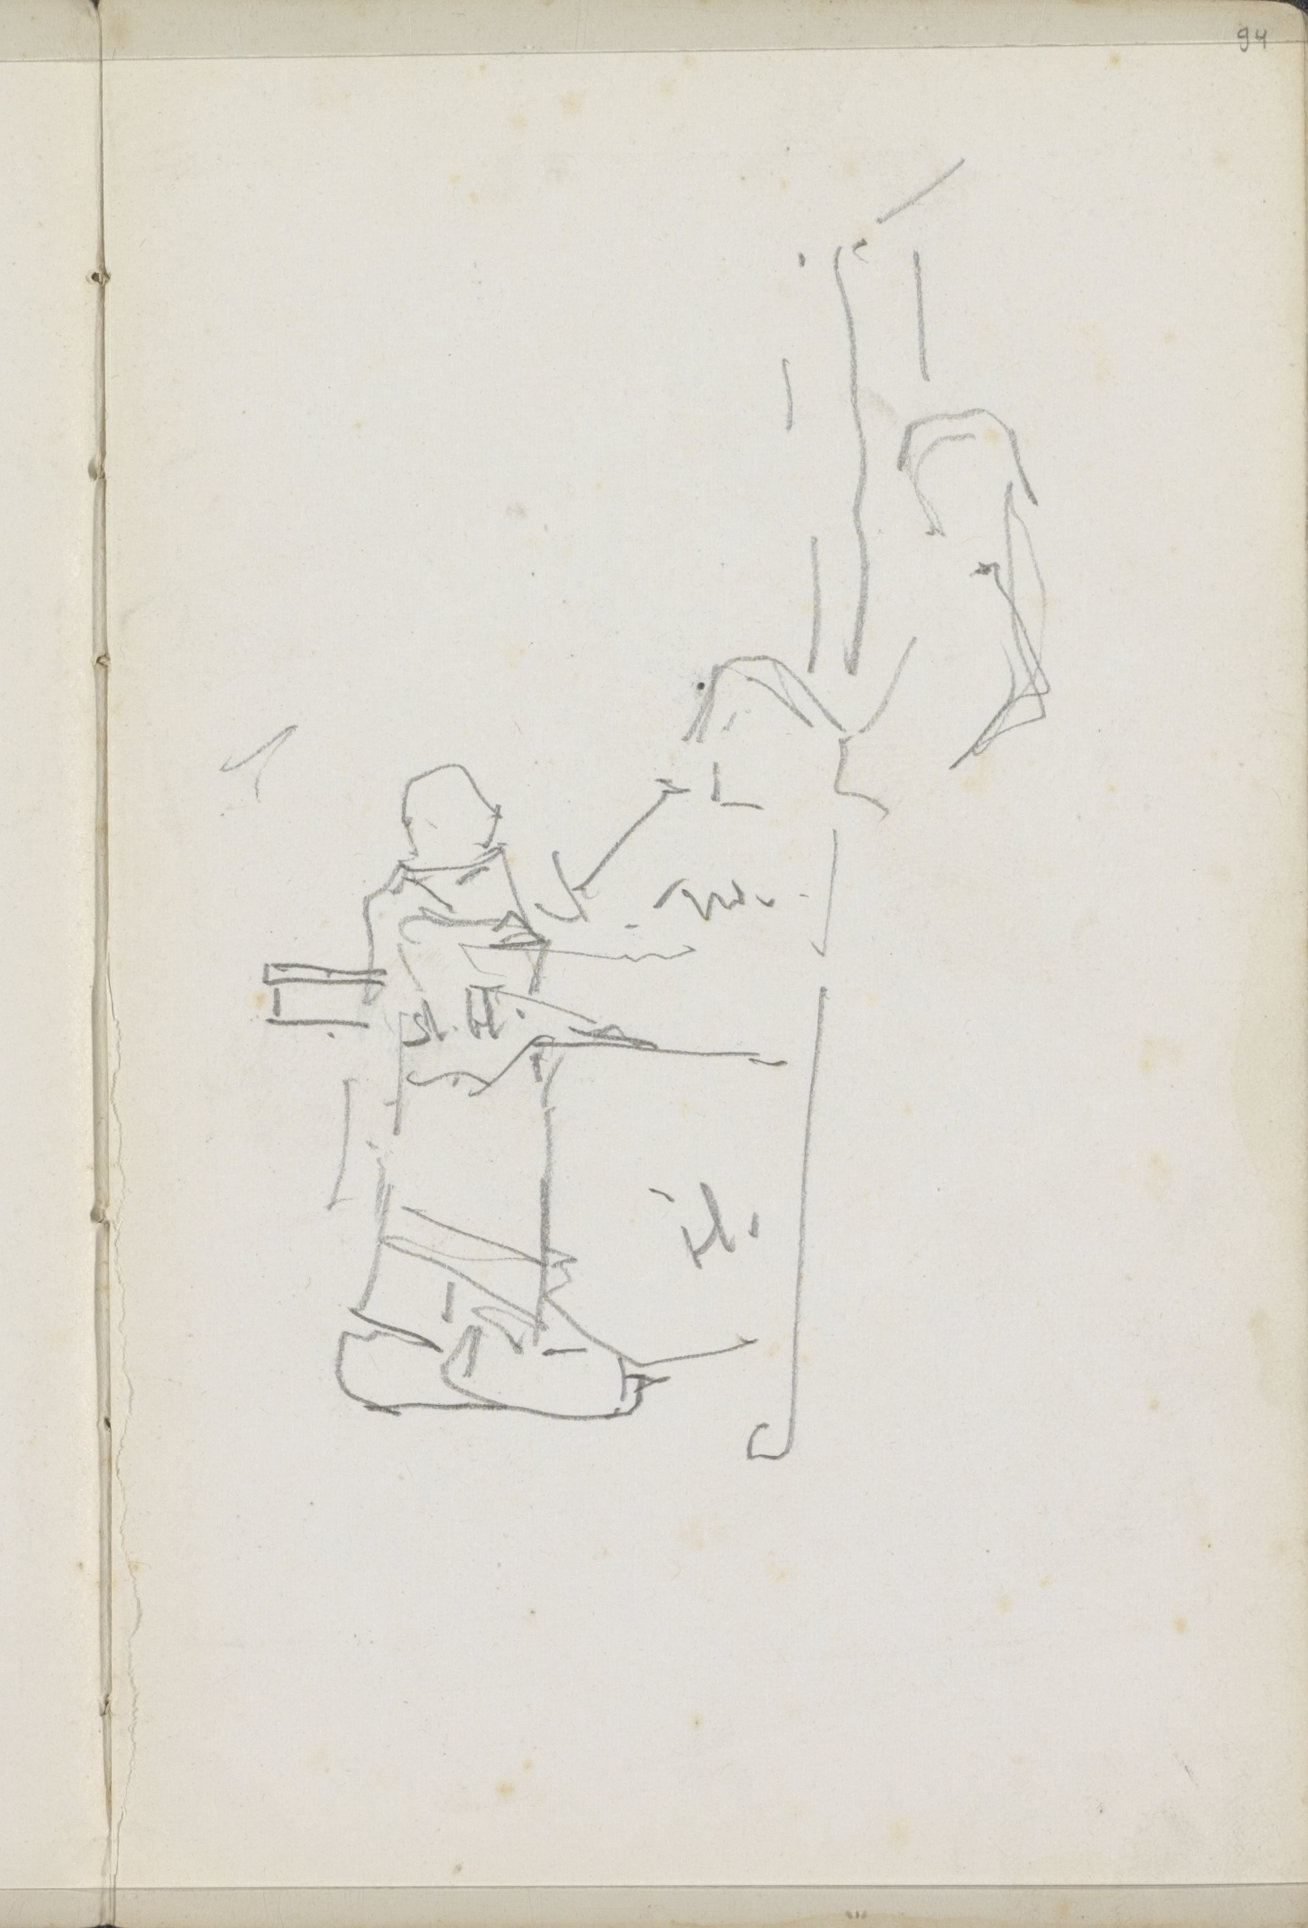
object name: sketchbook leaf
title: Drie figuren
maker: george hendrik breitner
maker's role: draughtsman, painter, print maker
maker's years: 1857-1923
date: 1880-1882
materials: paper, pencil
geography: south holland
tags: adult woman, child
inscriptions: kleurnotitie, handgeschreven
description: Mogelijk twee vrouwen en een kind. Pagina 94 uit een schetsboek met 72 bladen.